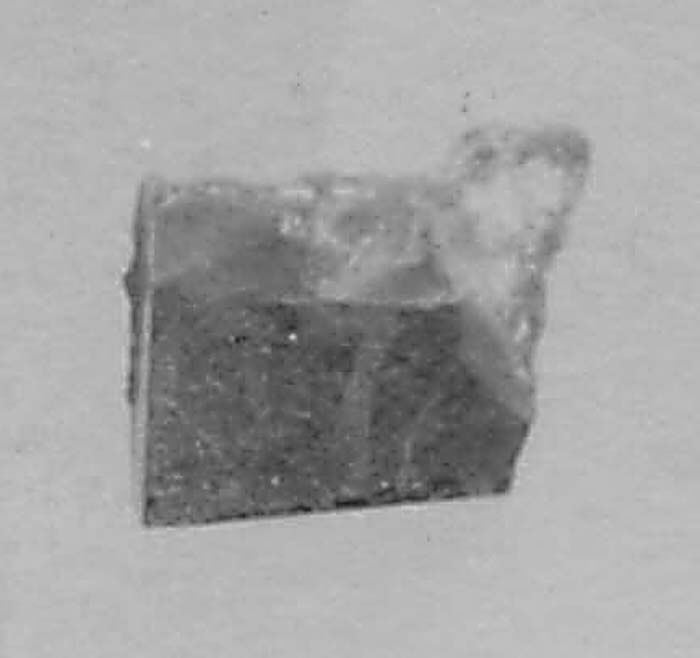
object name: fragment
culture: turkestani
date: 1902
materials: jade